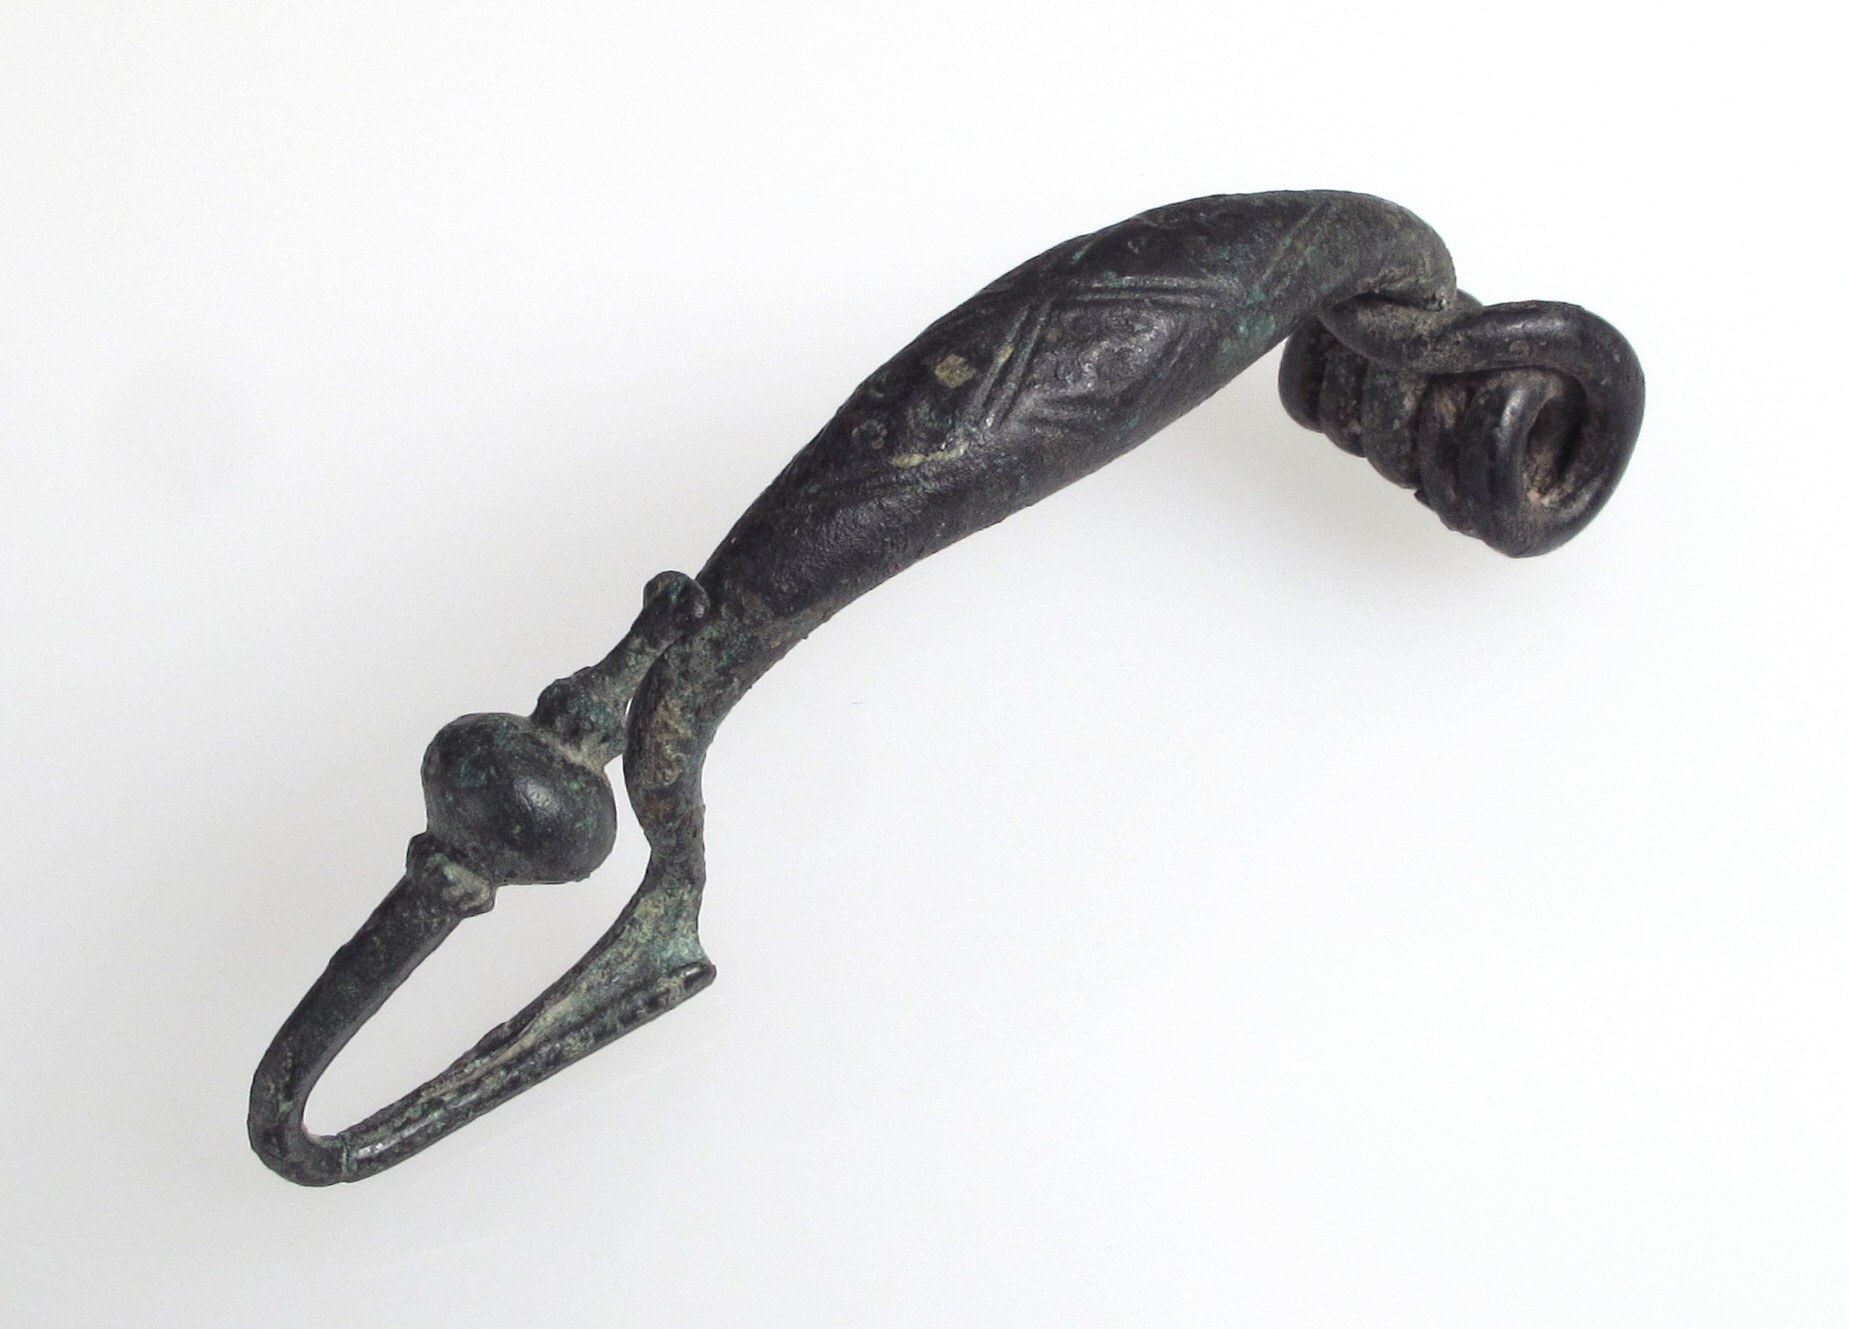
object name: brooch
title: Bow Brooch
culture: celtic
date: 500-301 BCE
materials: copper alloy